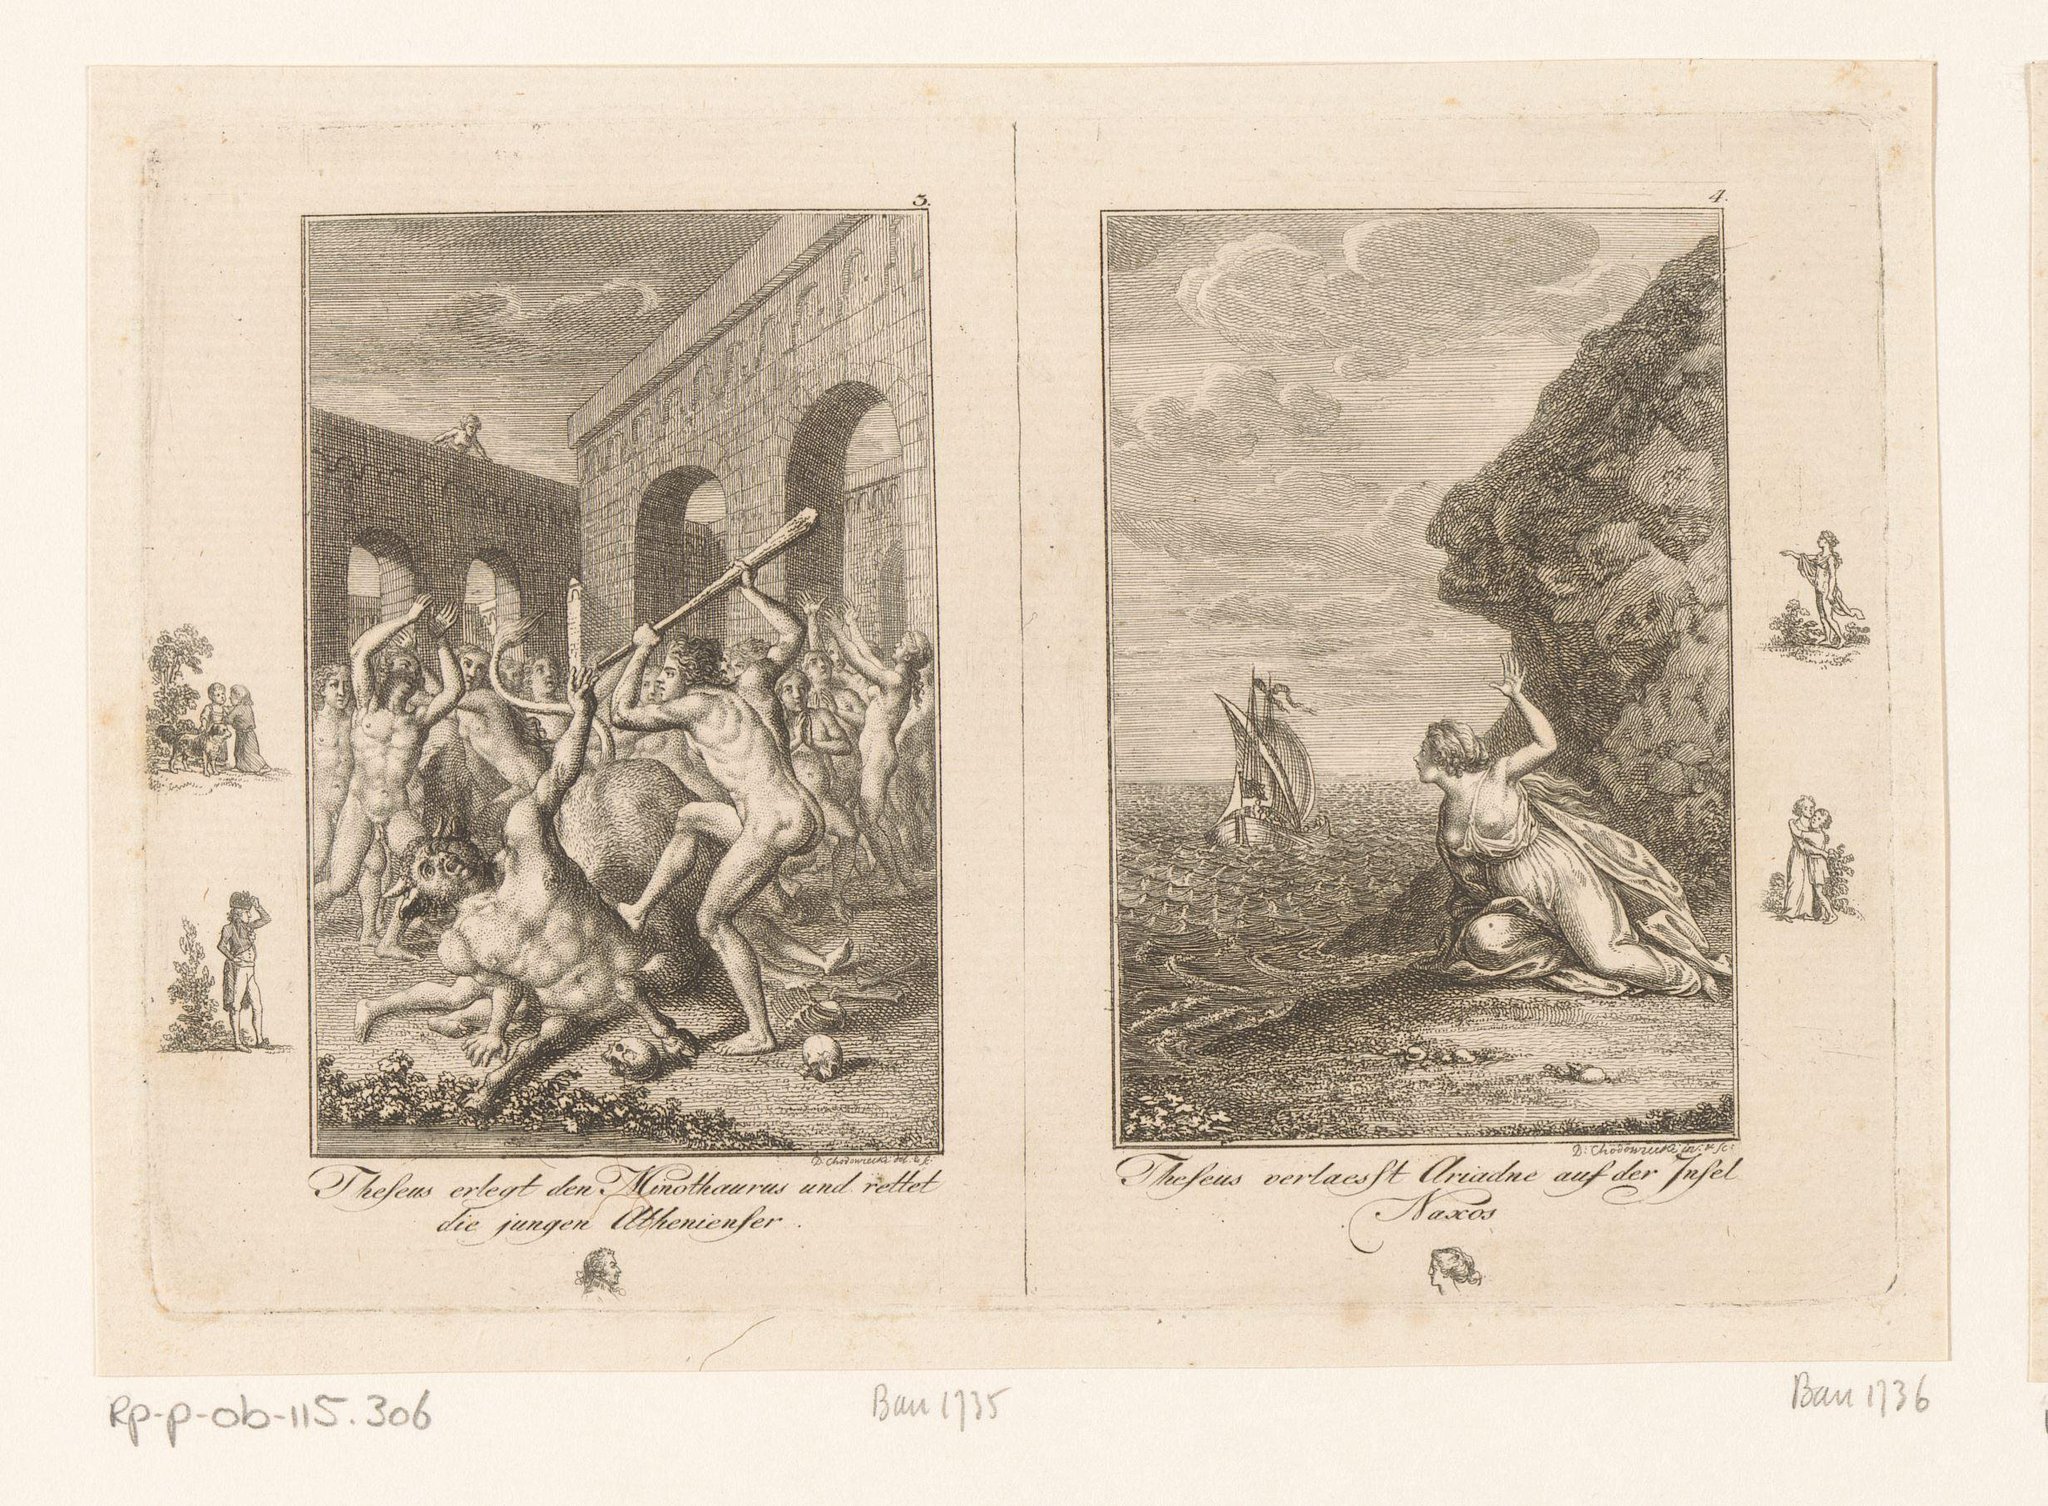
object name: print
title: Twee voorstellingen uit het leven van Theseus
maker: daniel nikolaus chodowiecki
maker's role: draughtsman, print maker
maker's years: 1726-1801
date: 1794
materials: paper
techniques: etching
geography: berlin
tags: theseus kills the minotaur, ariadne left behind on the island of naxos, (story of) theseus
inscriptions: collector's mark: Lugt 2228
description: Links: Theseus verslaat de Minotaurus. Rechts: Theseus laat Ariadne treurend achter op Naxos. Met onderschrift in het Duits en linksboven genummerd: 3,4. In de marge zijn op schetsmatige wijze verschillende koppen en figuren geëtst.